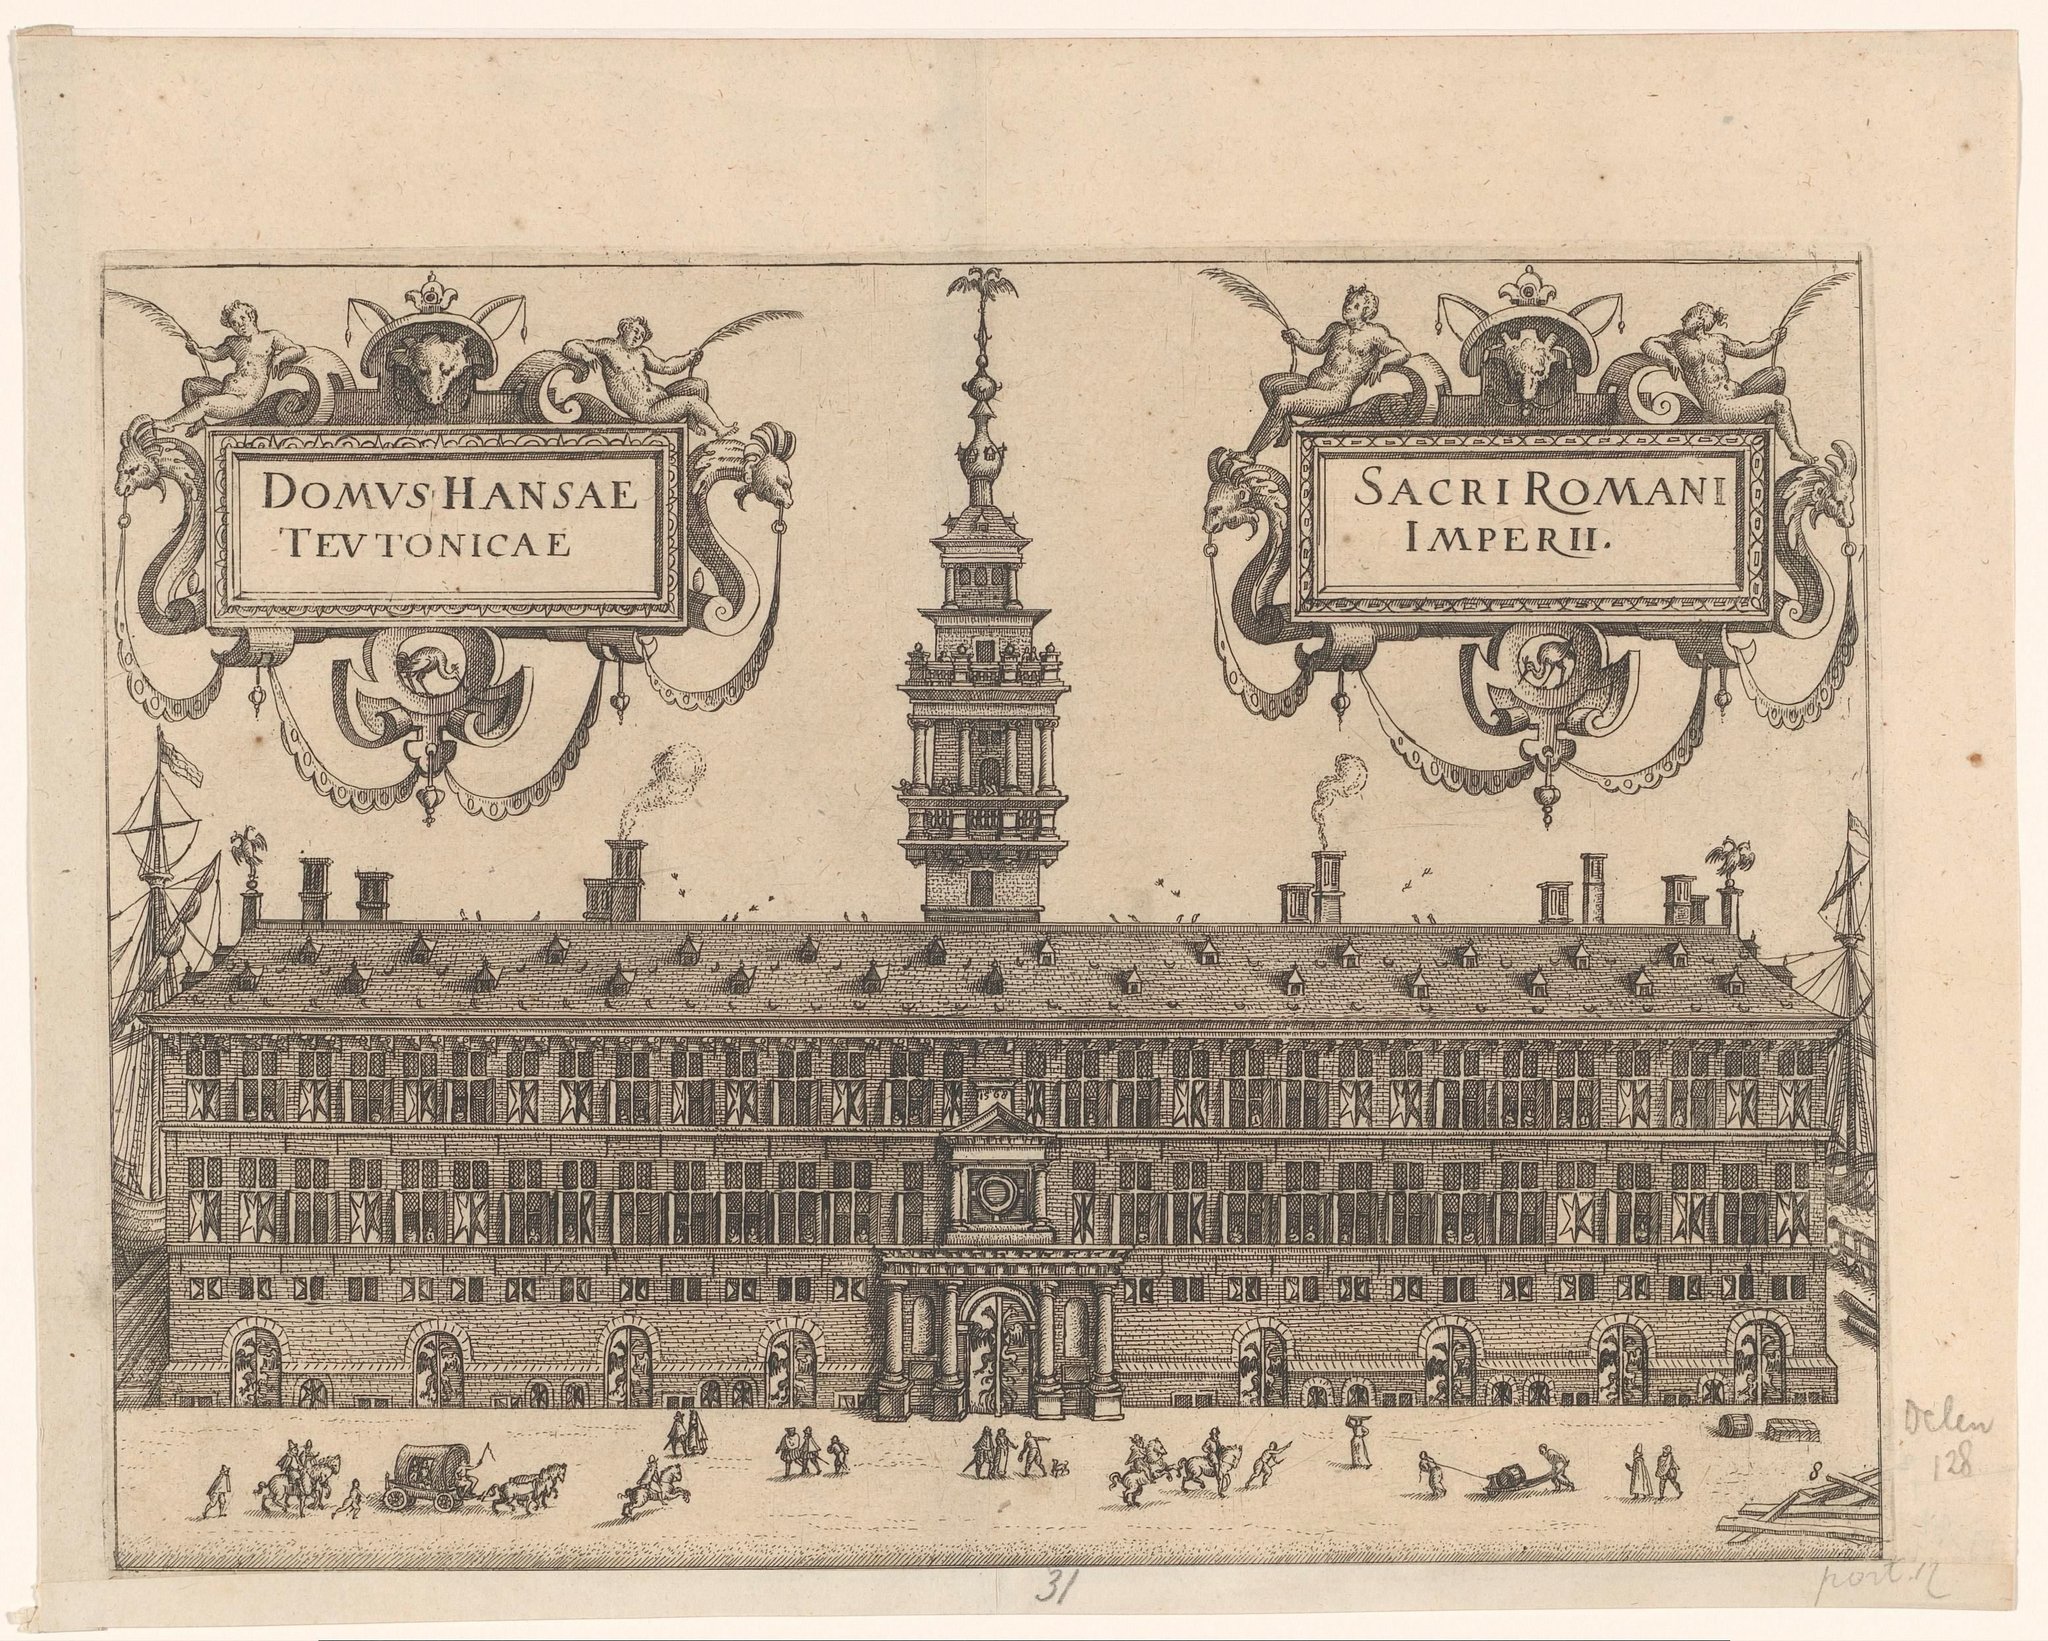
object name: print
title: Gezicht op het Oostershuis te Antwerpen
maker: Anonymous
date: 1612-1648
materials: paper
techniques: engraving, etching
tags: locations for trading, persons engaged in trade and commerce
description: Deze staat van prent voor het eerst gebruikt in: Guicciardini, Lodovico. Beschryvinghe van alle de Neder-landen, anderssins ghenoemt Neder-Duytslandt (…). Amsterdam: Willem Janszoon Blaeu, 1612. Hierna is deze prent tot 1648 nog gebruikt in latere uitgaven van deze publicatie, uitgegeven door Blaeu en daarna door Janssonius. Uit welke uitgave het huidige exemplaar precies komt is niet na te gaan.